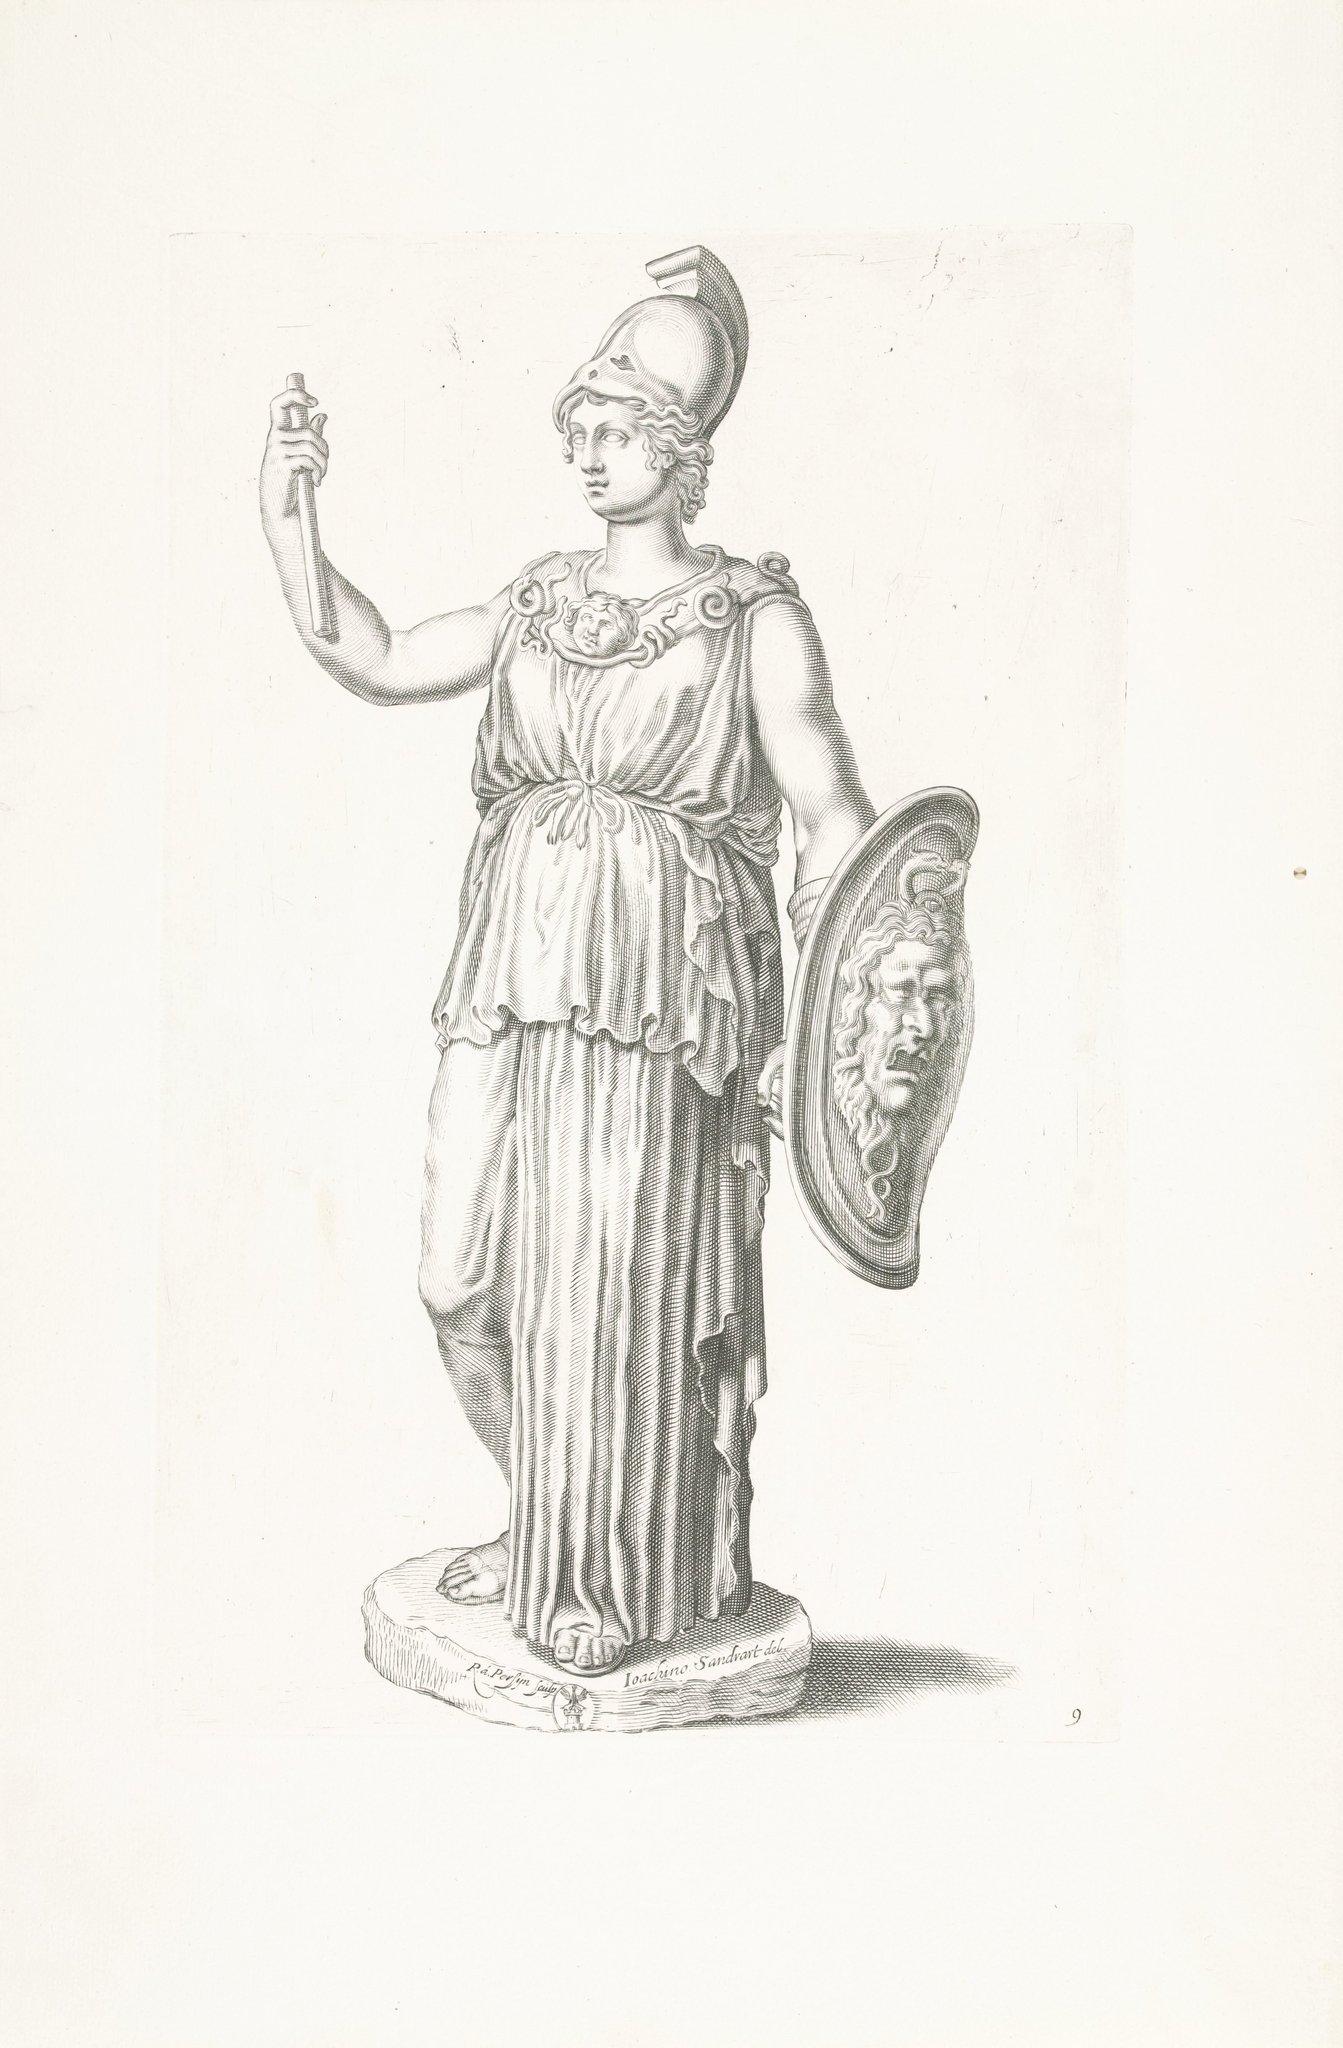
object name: print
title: Standbeeld van Minerva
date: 1640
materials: paper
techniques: engraving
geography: rome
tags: rome, vincenzo giustiniani (1564-1637), (story of) minerva (pallas, athena), piece of sculpture, reproduction of a piece of sculpture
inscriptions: collector's mark: Lugt 2228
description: Standbeeld van Minerva, in klassiek gewaad, met het Medusaschild in de hand. Midden onder op de basis het wapenschild van Vincenzo Giustiniani. Prent uit een publicatie met reproductieprenten naar de sculpturen in de verzameling in de Galleria Giustiniani te Rome.